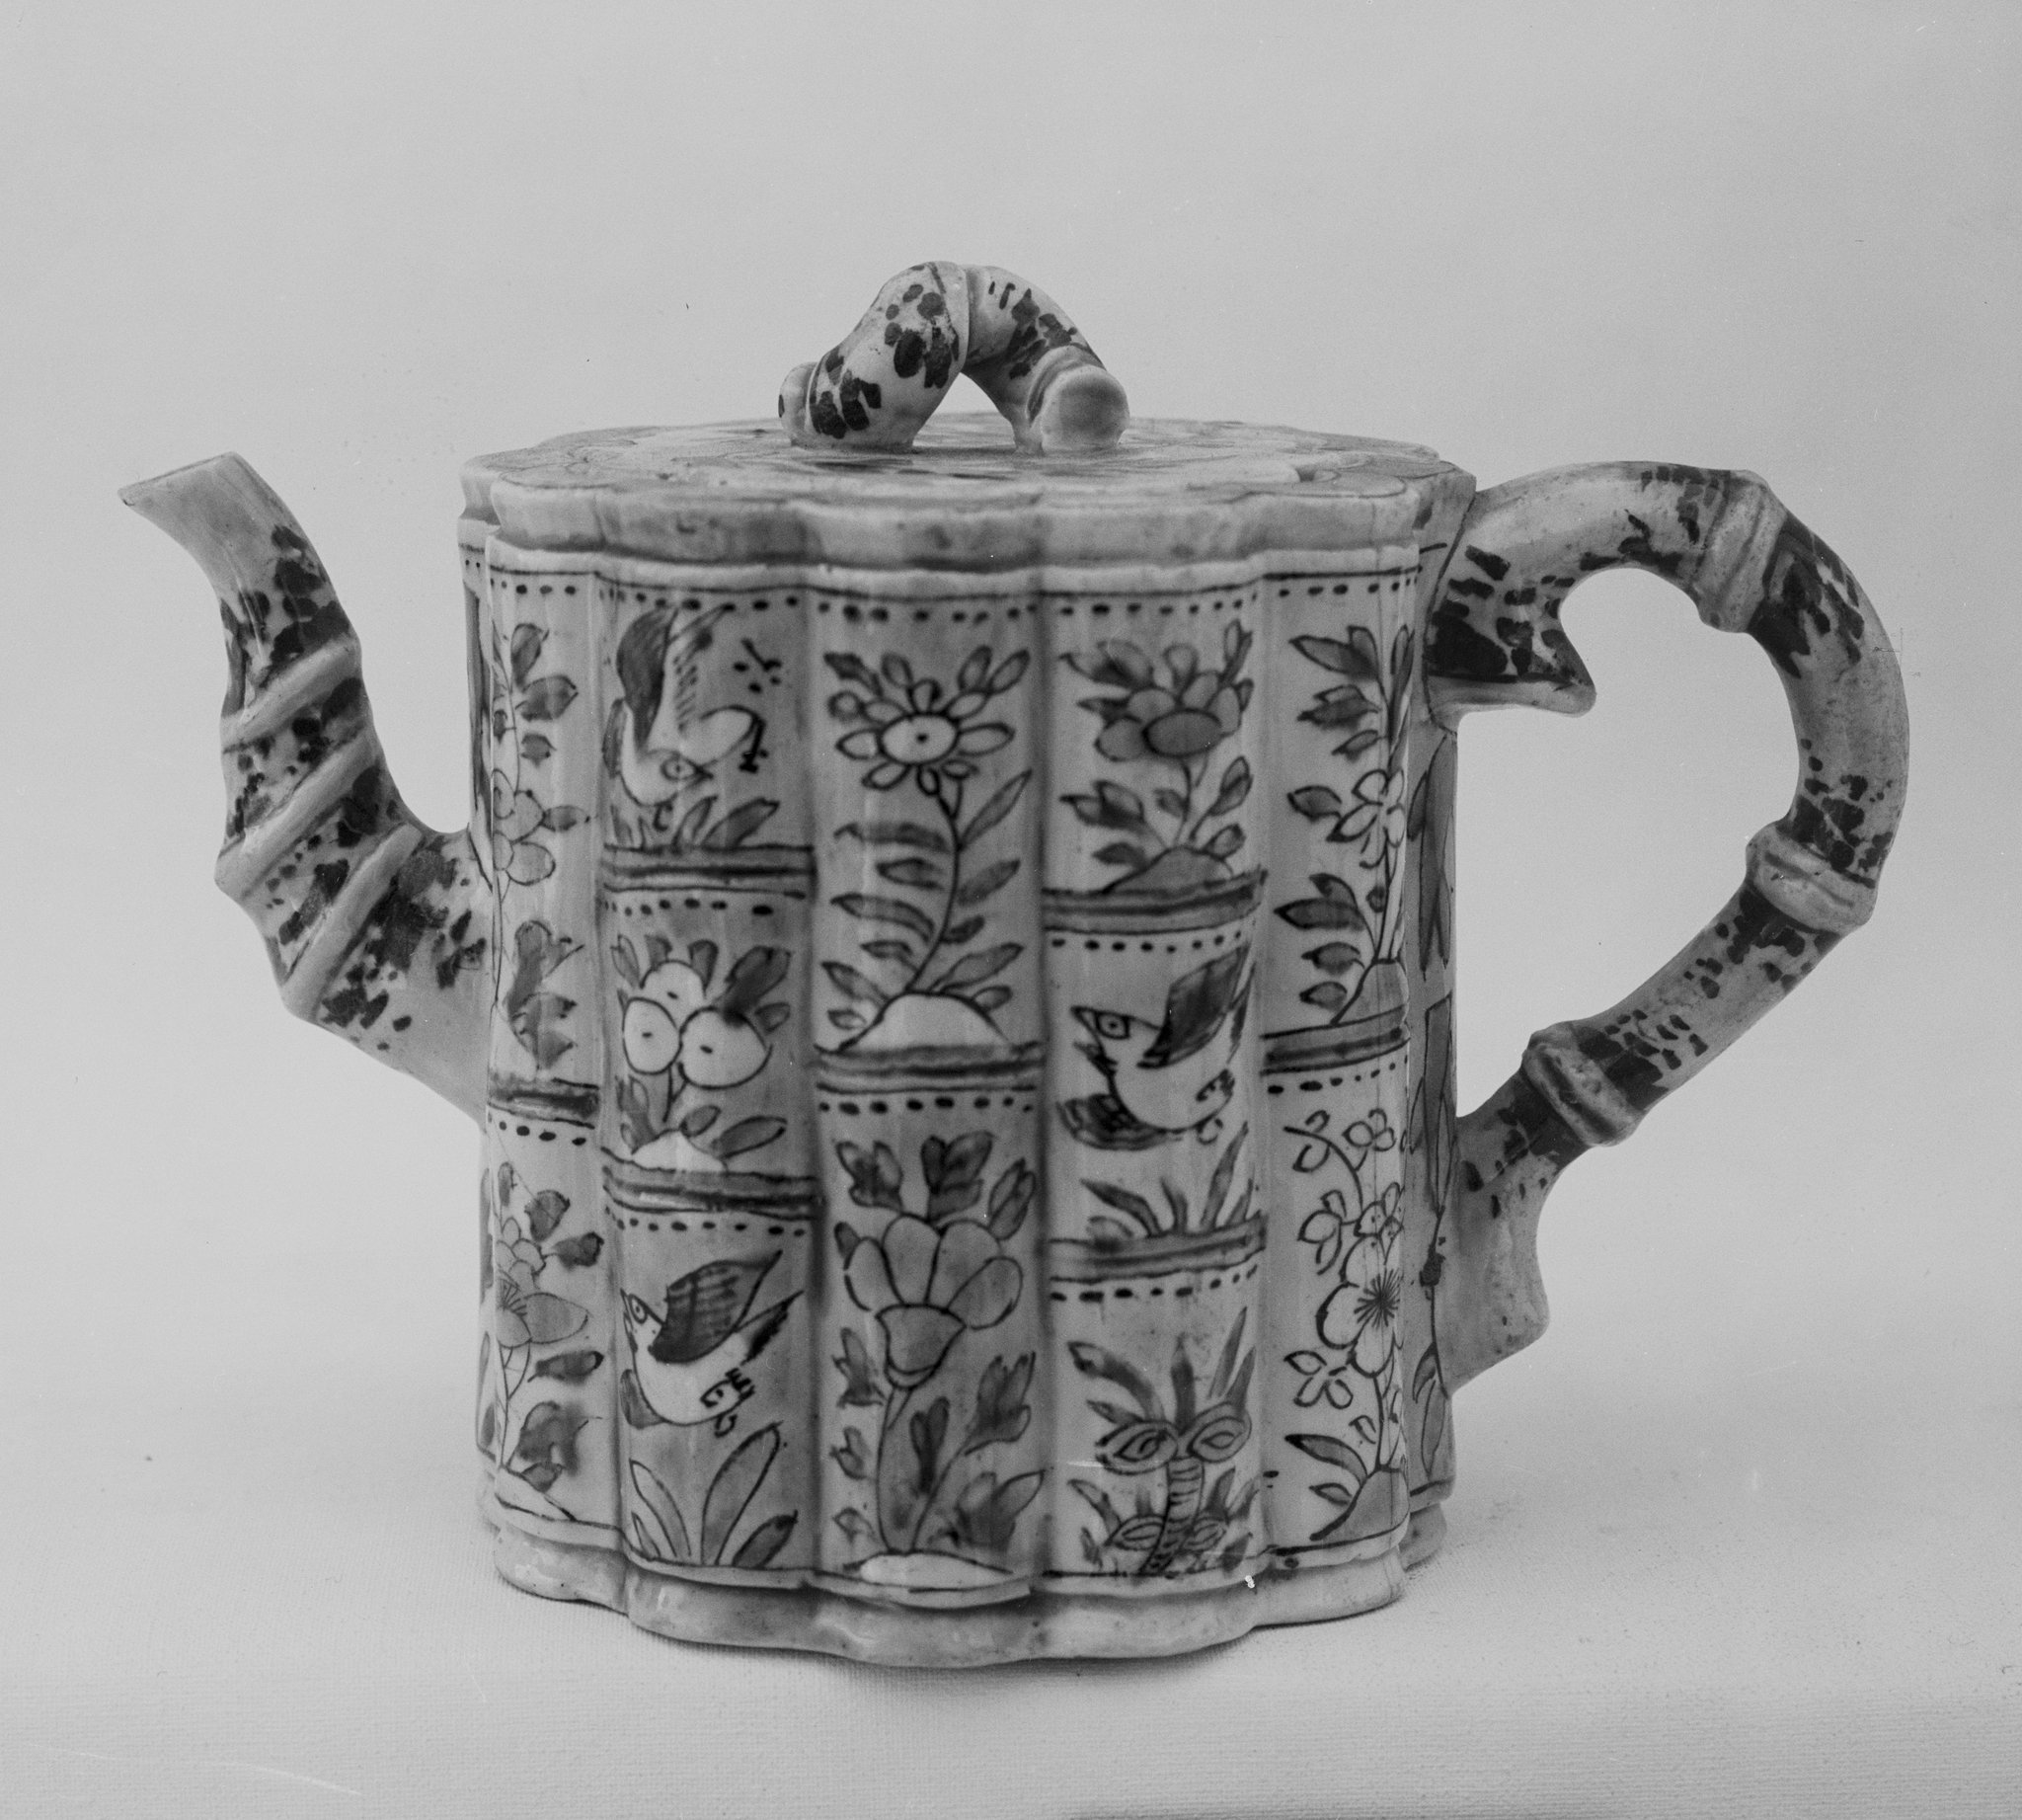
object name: teapot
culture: chinese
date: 1662-1722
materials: biscuit, enamel, porcelain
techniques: painting